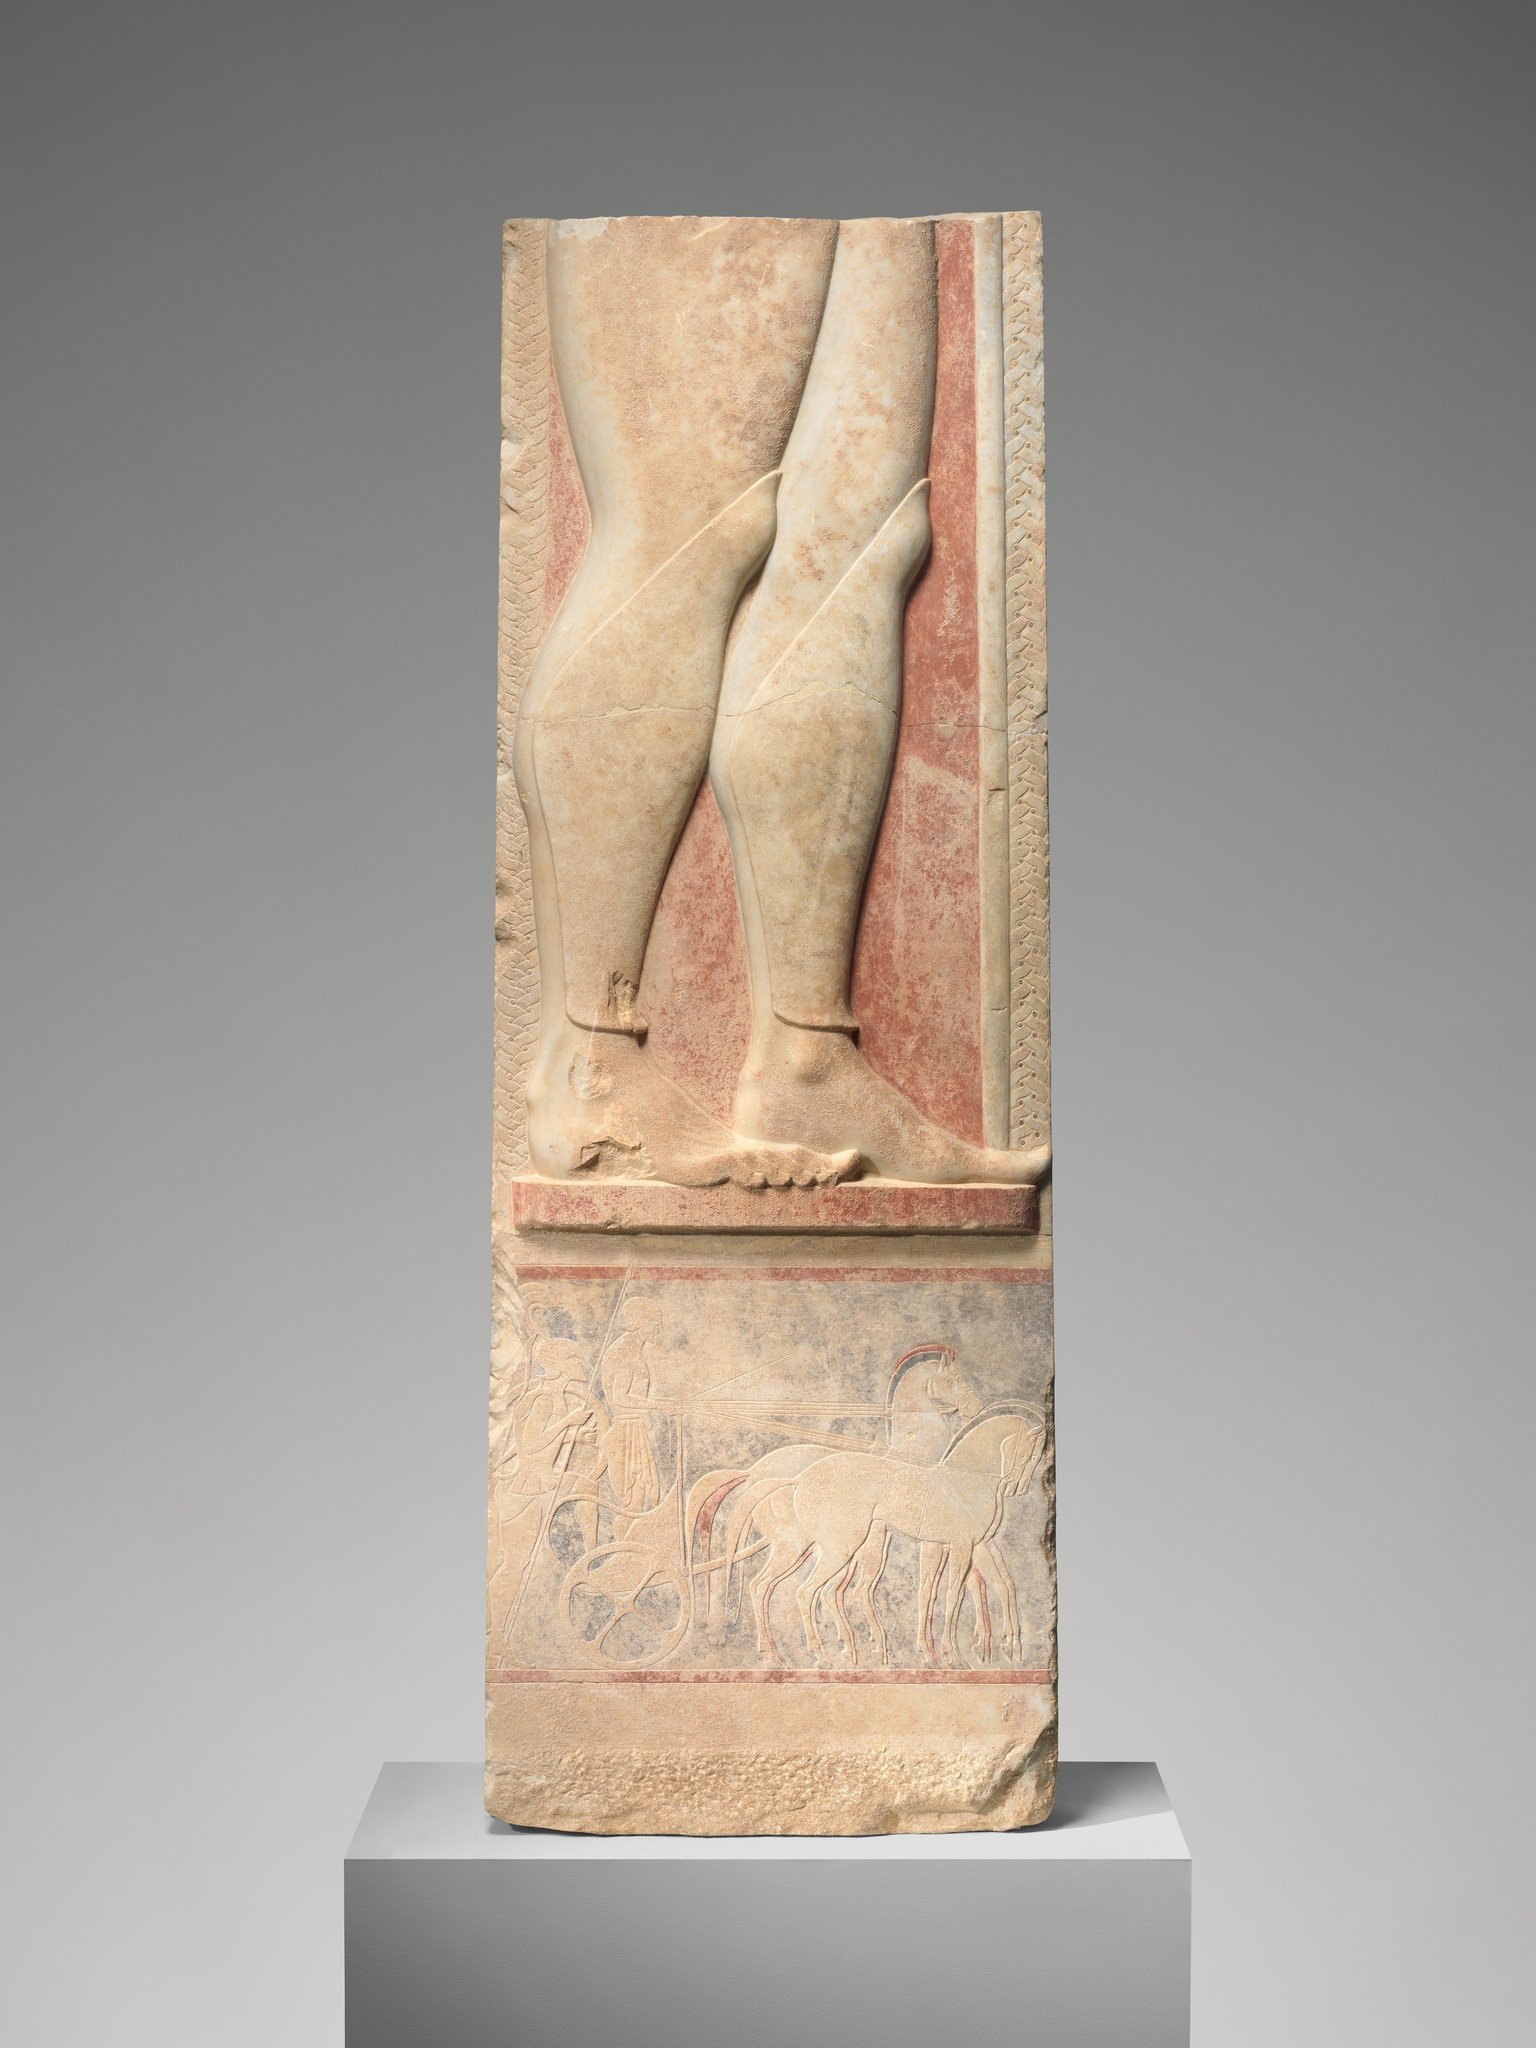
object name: grave stele fragment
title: Fragment of the marble stele (grave marker) of a hoplite (foot soldier)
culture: greek, attic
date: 525-515 BCE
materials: marble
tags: soldiers,horses,chariots,legs